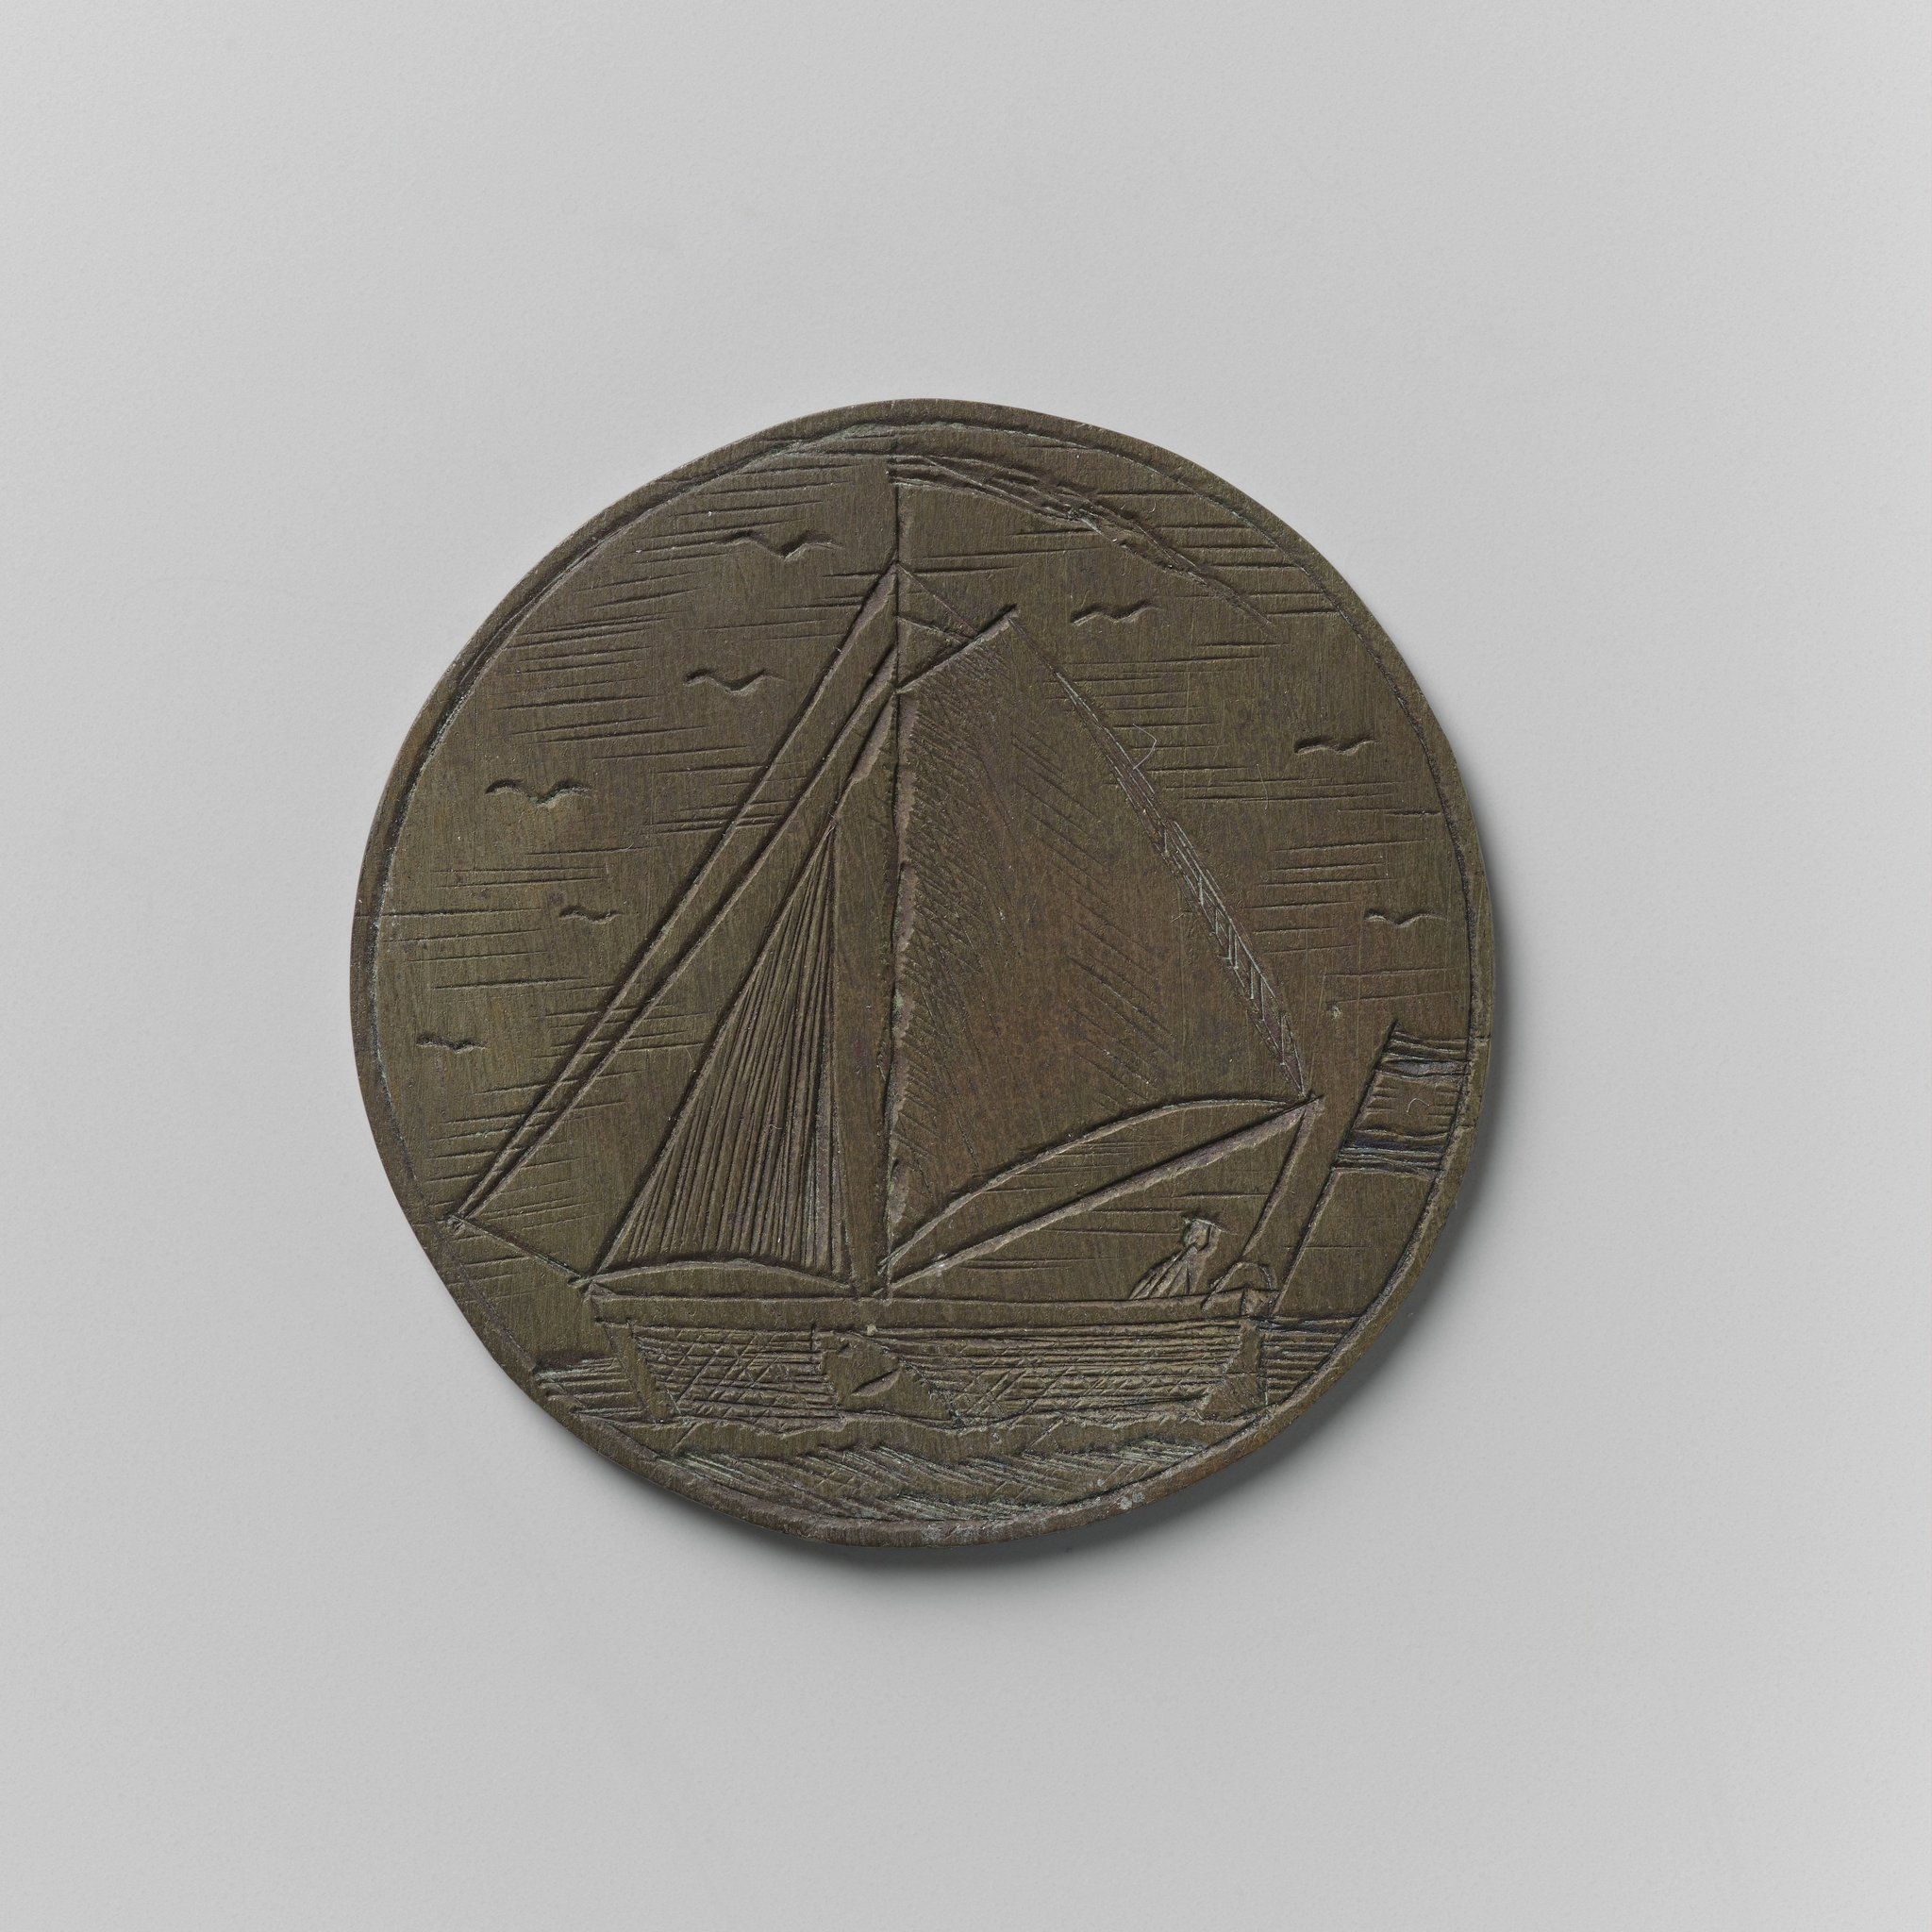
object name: medal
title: Roei-, steiger- en schuitenvoerdersgilde van Amsterdam, gildepenning van Gerrit Kempen, ligplaats Kalkmarkt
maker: Anonymous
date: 1811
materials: brass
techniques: engraving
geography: amsterdam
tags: amsterdam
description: Messing penning. Voorzijde: naar links varende zeilboot; op achterplecht: zittende man en vlag. Keerzijde: huismerk tussen letters K en M boven hart met daarin letters G en K binnen bladerkrans en omschrift